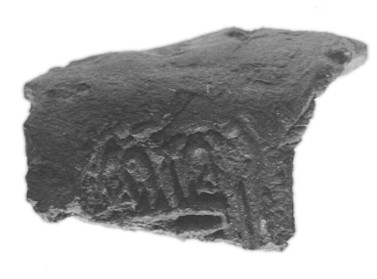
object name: sealing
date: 2030-1640 BCE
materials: clay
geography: egypt